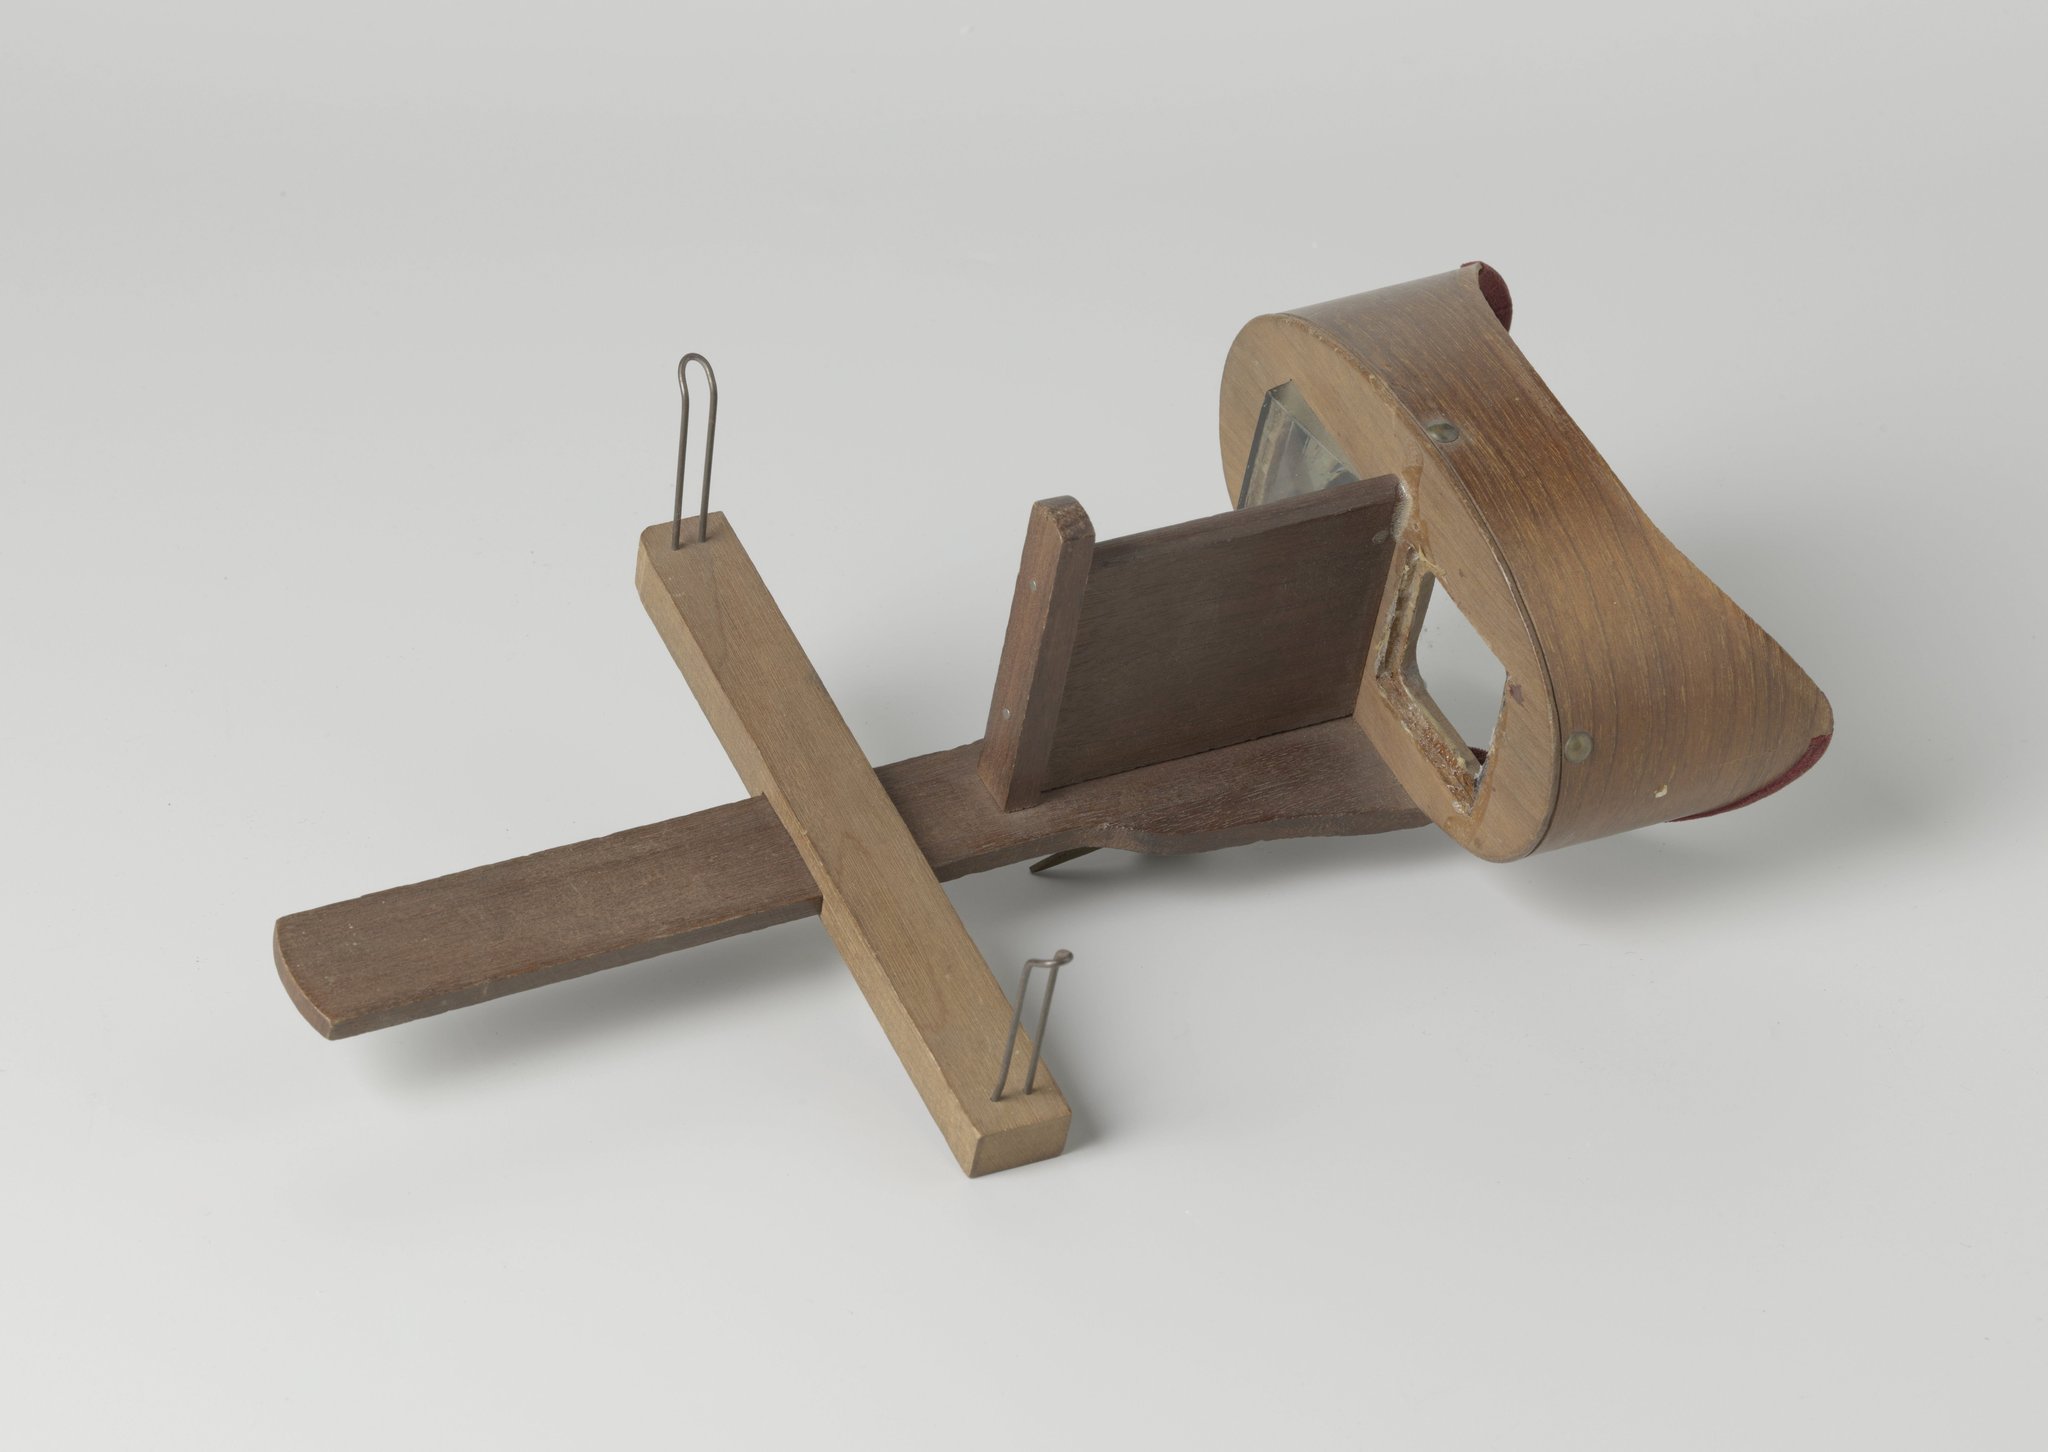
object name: object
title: Stereokijker (type Holmes)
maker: Anonymous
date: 1400-1950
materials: glass, metal, wood